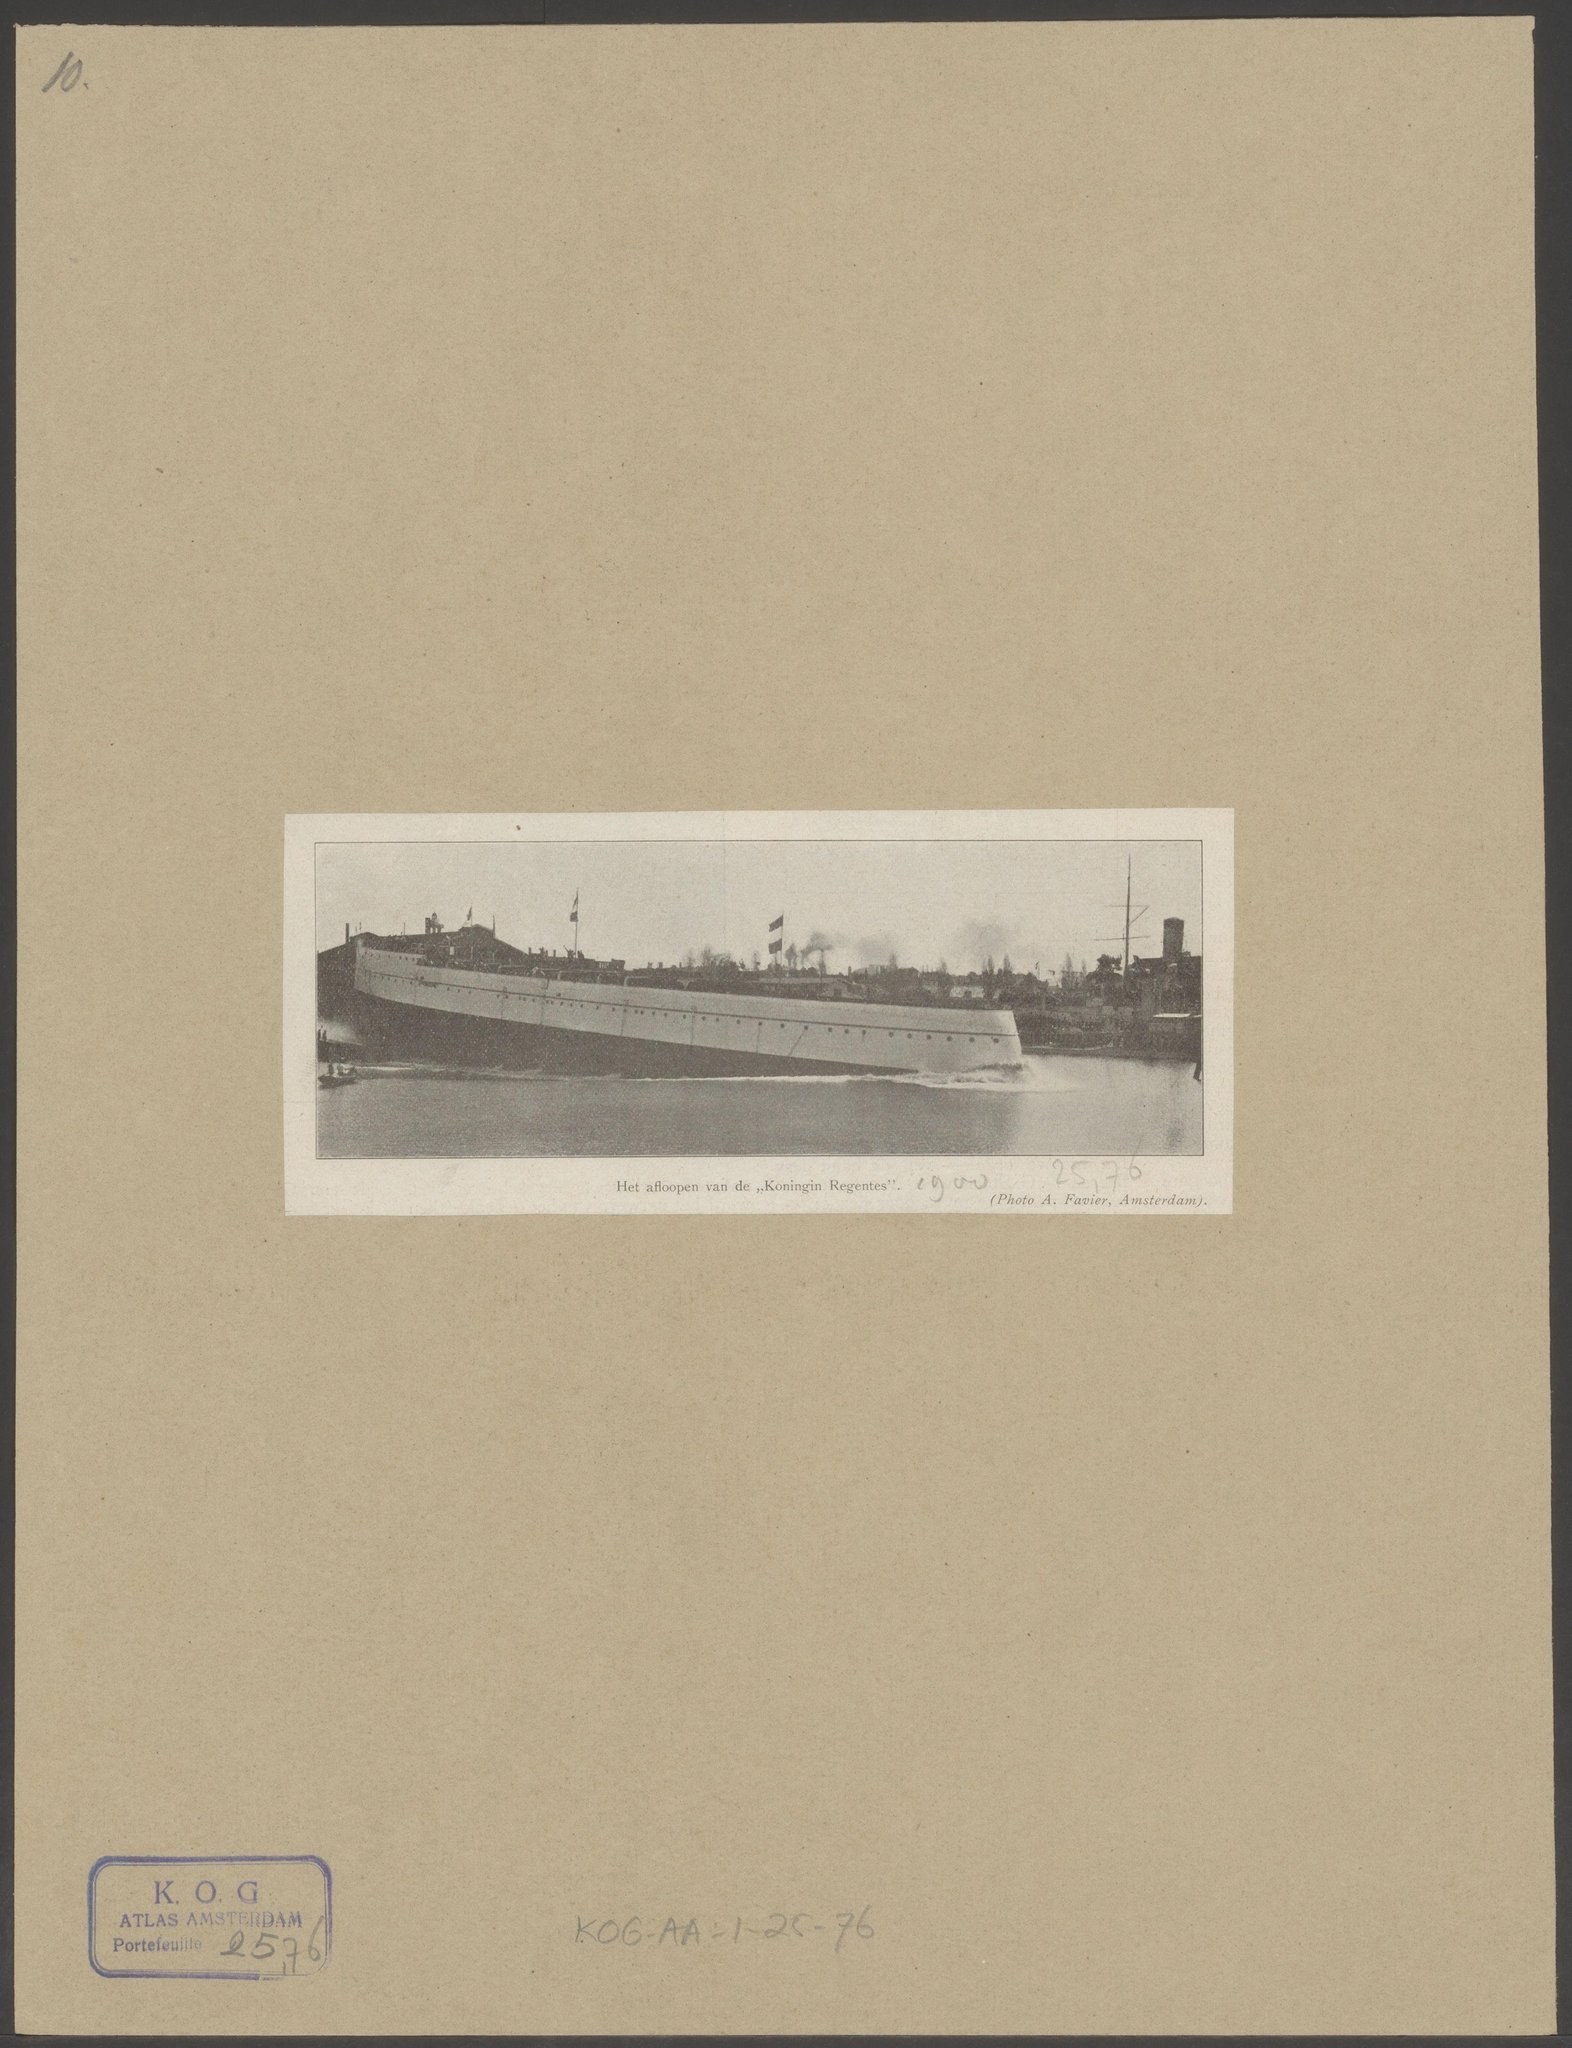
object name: photomechanical print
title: Het afloopen van de "Koningin Regentes"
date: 1900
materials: paper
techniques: letterpress printing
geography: amsterdam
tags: parts of ship's exterior, launching a ship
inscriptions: collector's mark: ‘25.76’ Lugt 1641b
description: Onderwerpsrubriek binnen de Atlas Amsterdam: Krijgswezen I: De Admiraliteit van Amsterdam, A. Admiraliteitsgebouwen.